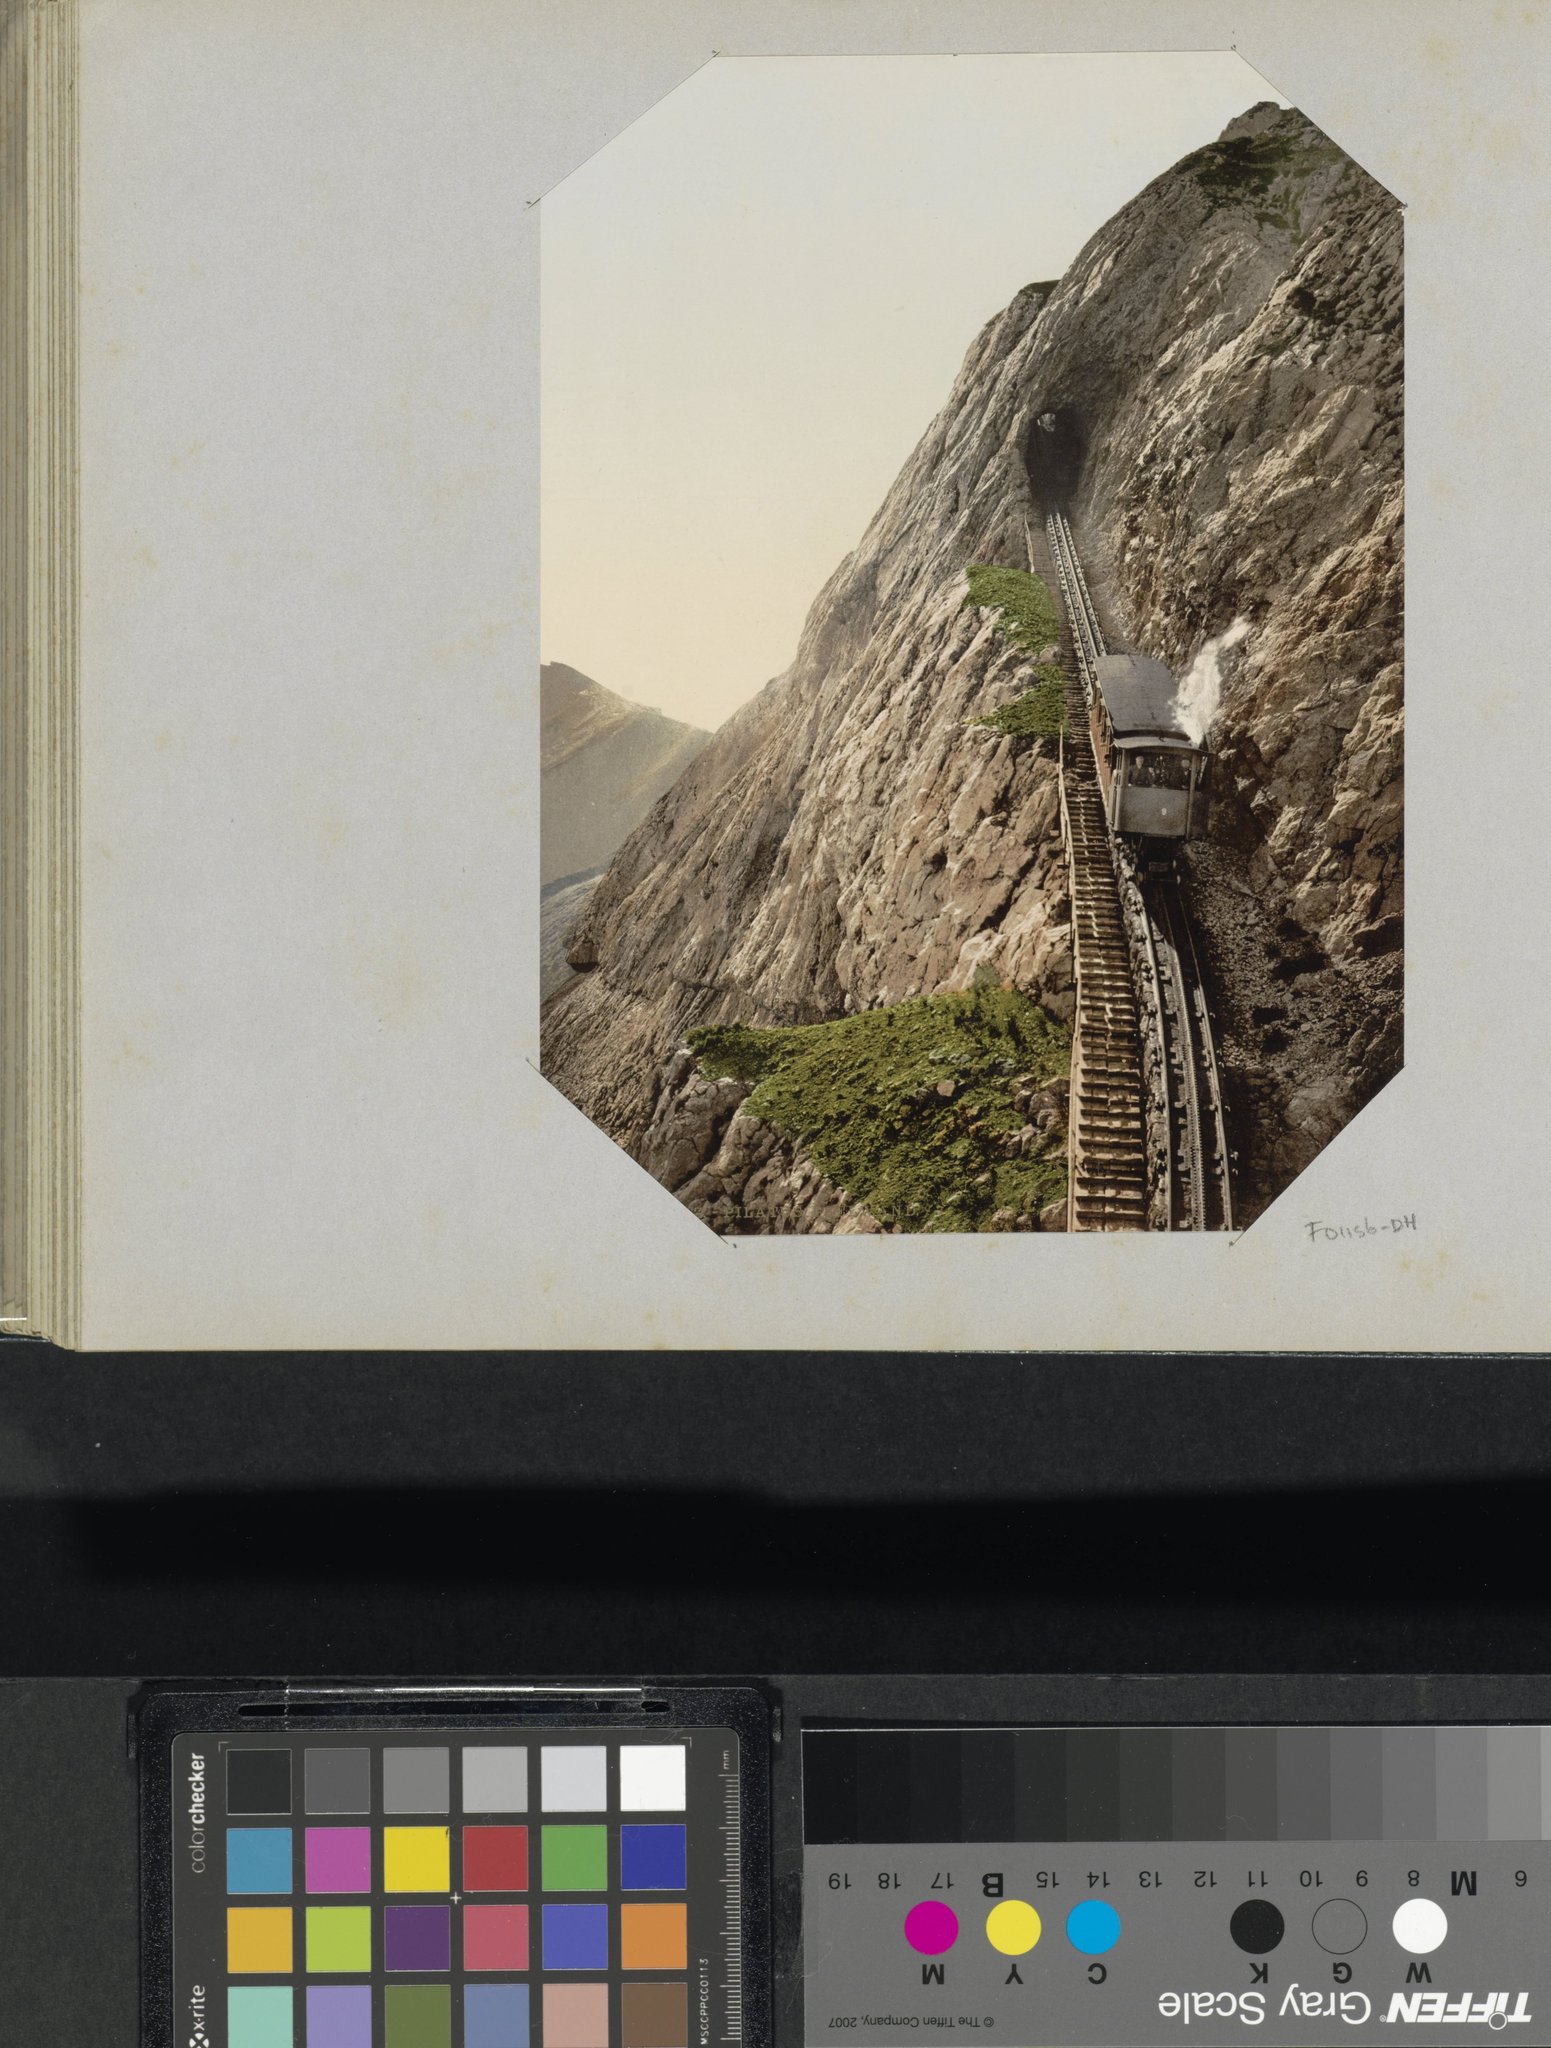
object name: album leaf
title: Gezicht op de Pilatusbahn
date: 1896-1897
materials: paper, photographic process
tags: rack railway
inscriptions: inscription: ‘6605. P.Z. - Pilatus. Eselwand’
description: Deze prent maakt deel uit van een album.